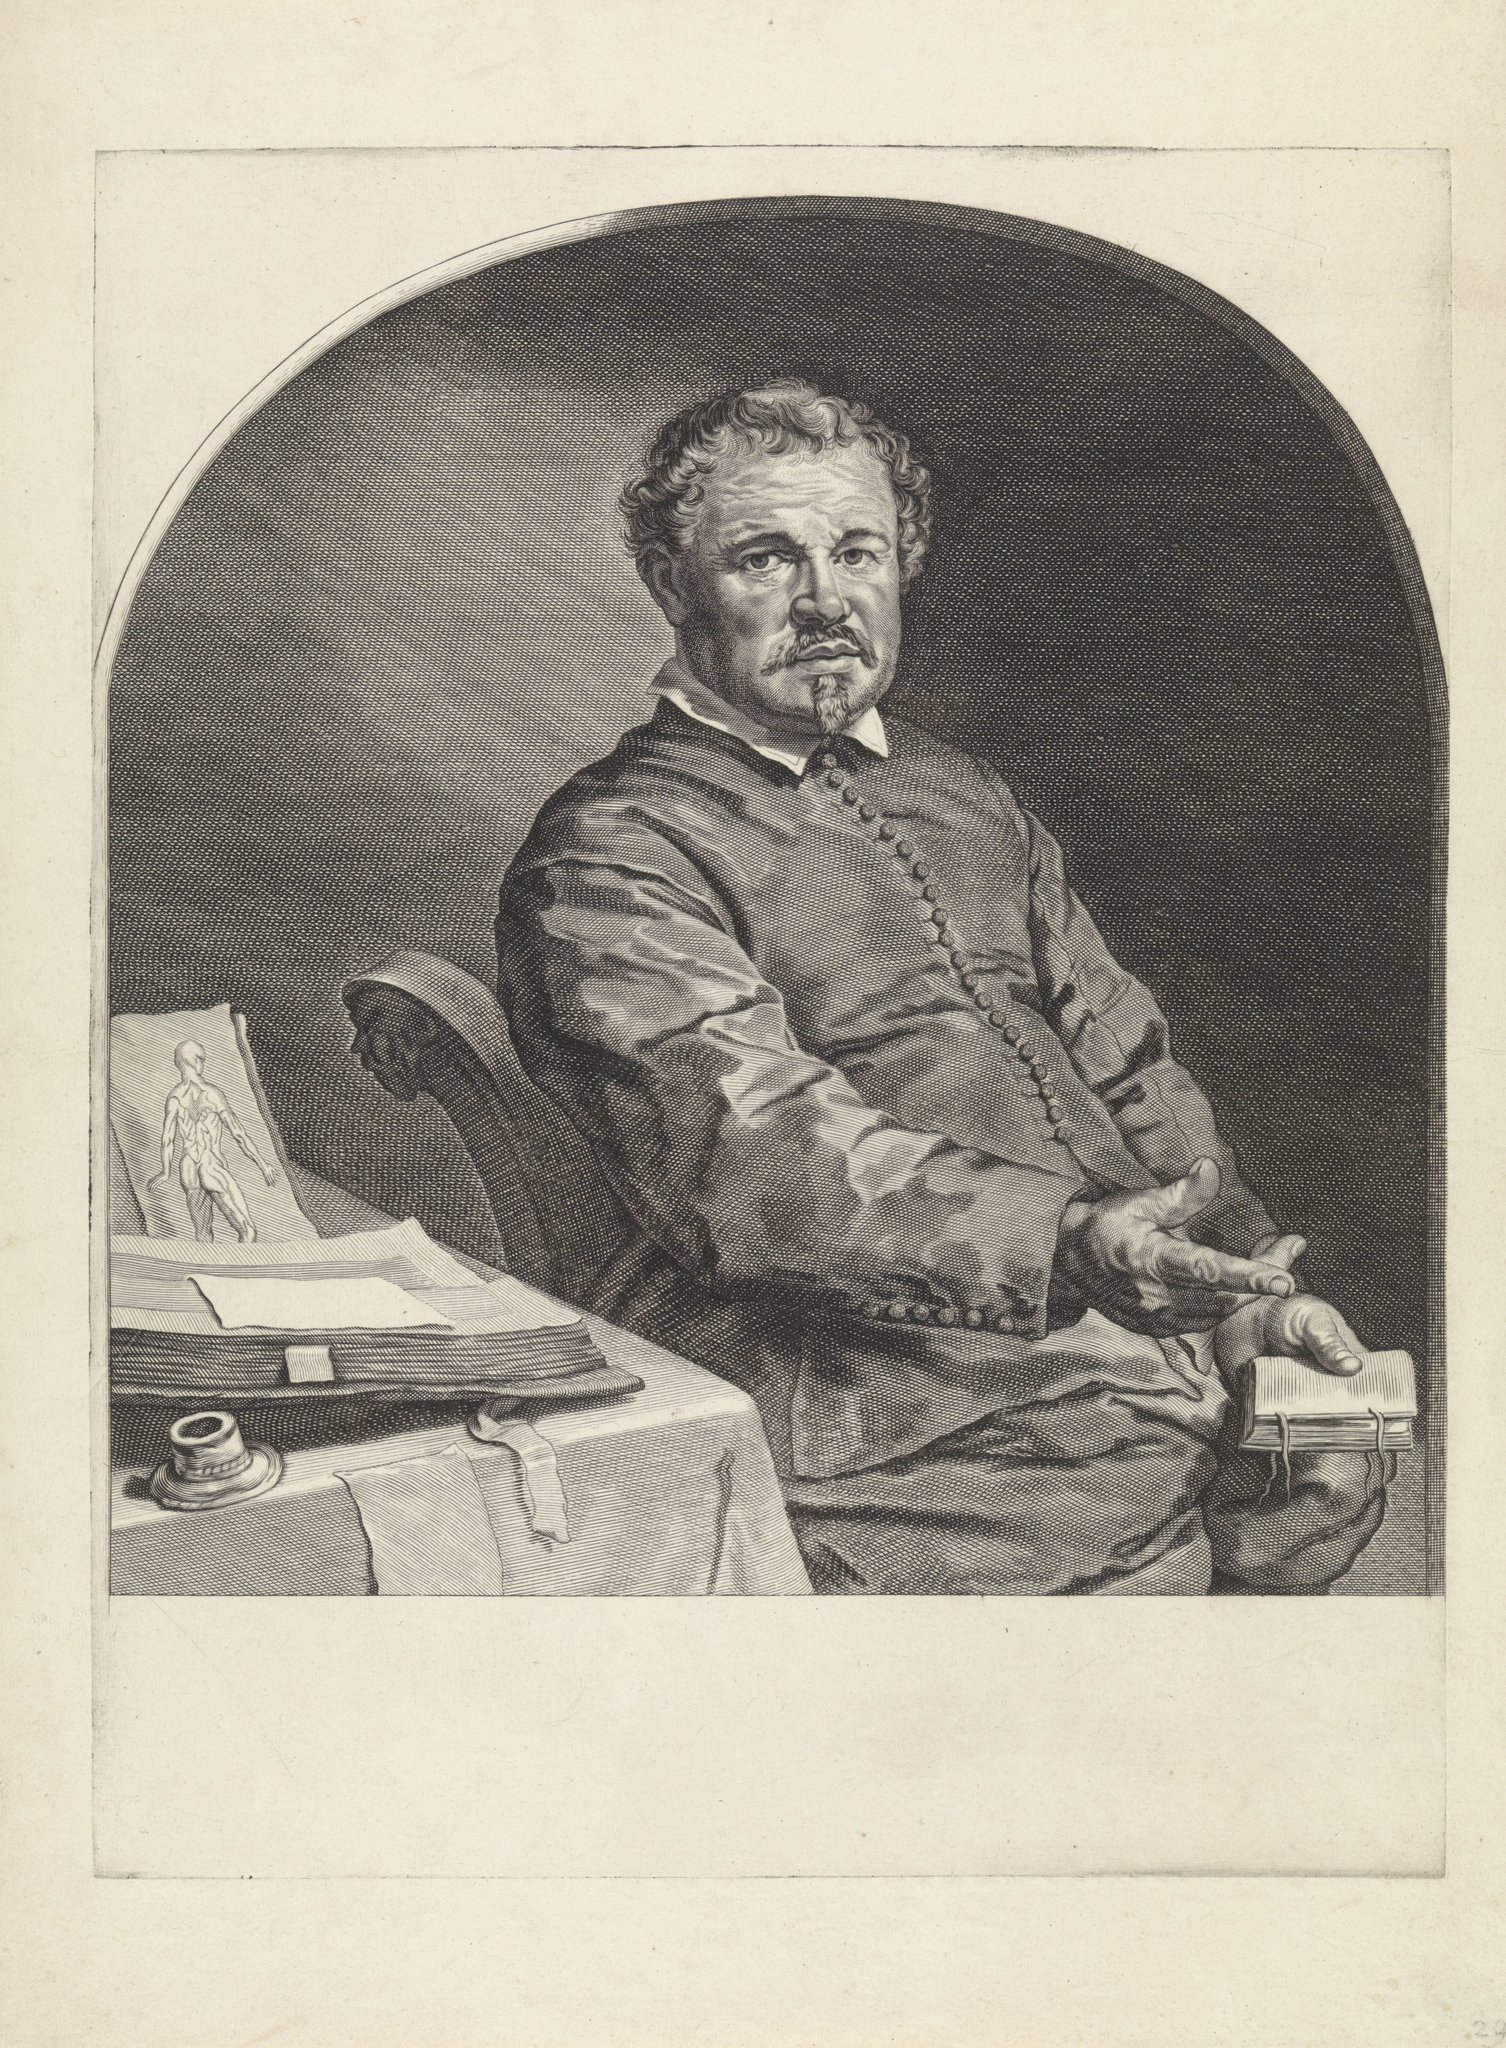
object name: print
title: Portret van Jacob Cornelisz.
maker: frederick hendrick van den hove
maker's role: print maker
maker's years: 1628-1698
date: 1660-1663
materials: paper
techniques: engraving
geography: amsterdam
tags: rotterdam, amsterdam, historical persons, anatomical model of the muscles, muscle-man, 'écorché'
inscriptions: collector's mark: Lugt 240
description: Portret van Jacob Cornelisz., predikant en chirurgijn in Amsterdam, zittend bij een tafel, met daarop een anatomische prent. In zijn hand een boekje, mogelijk een bijbel.